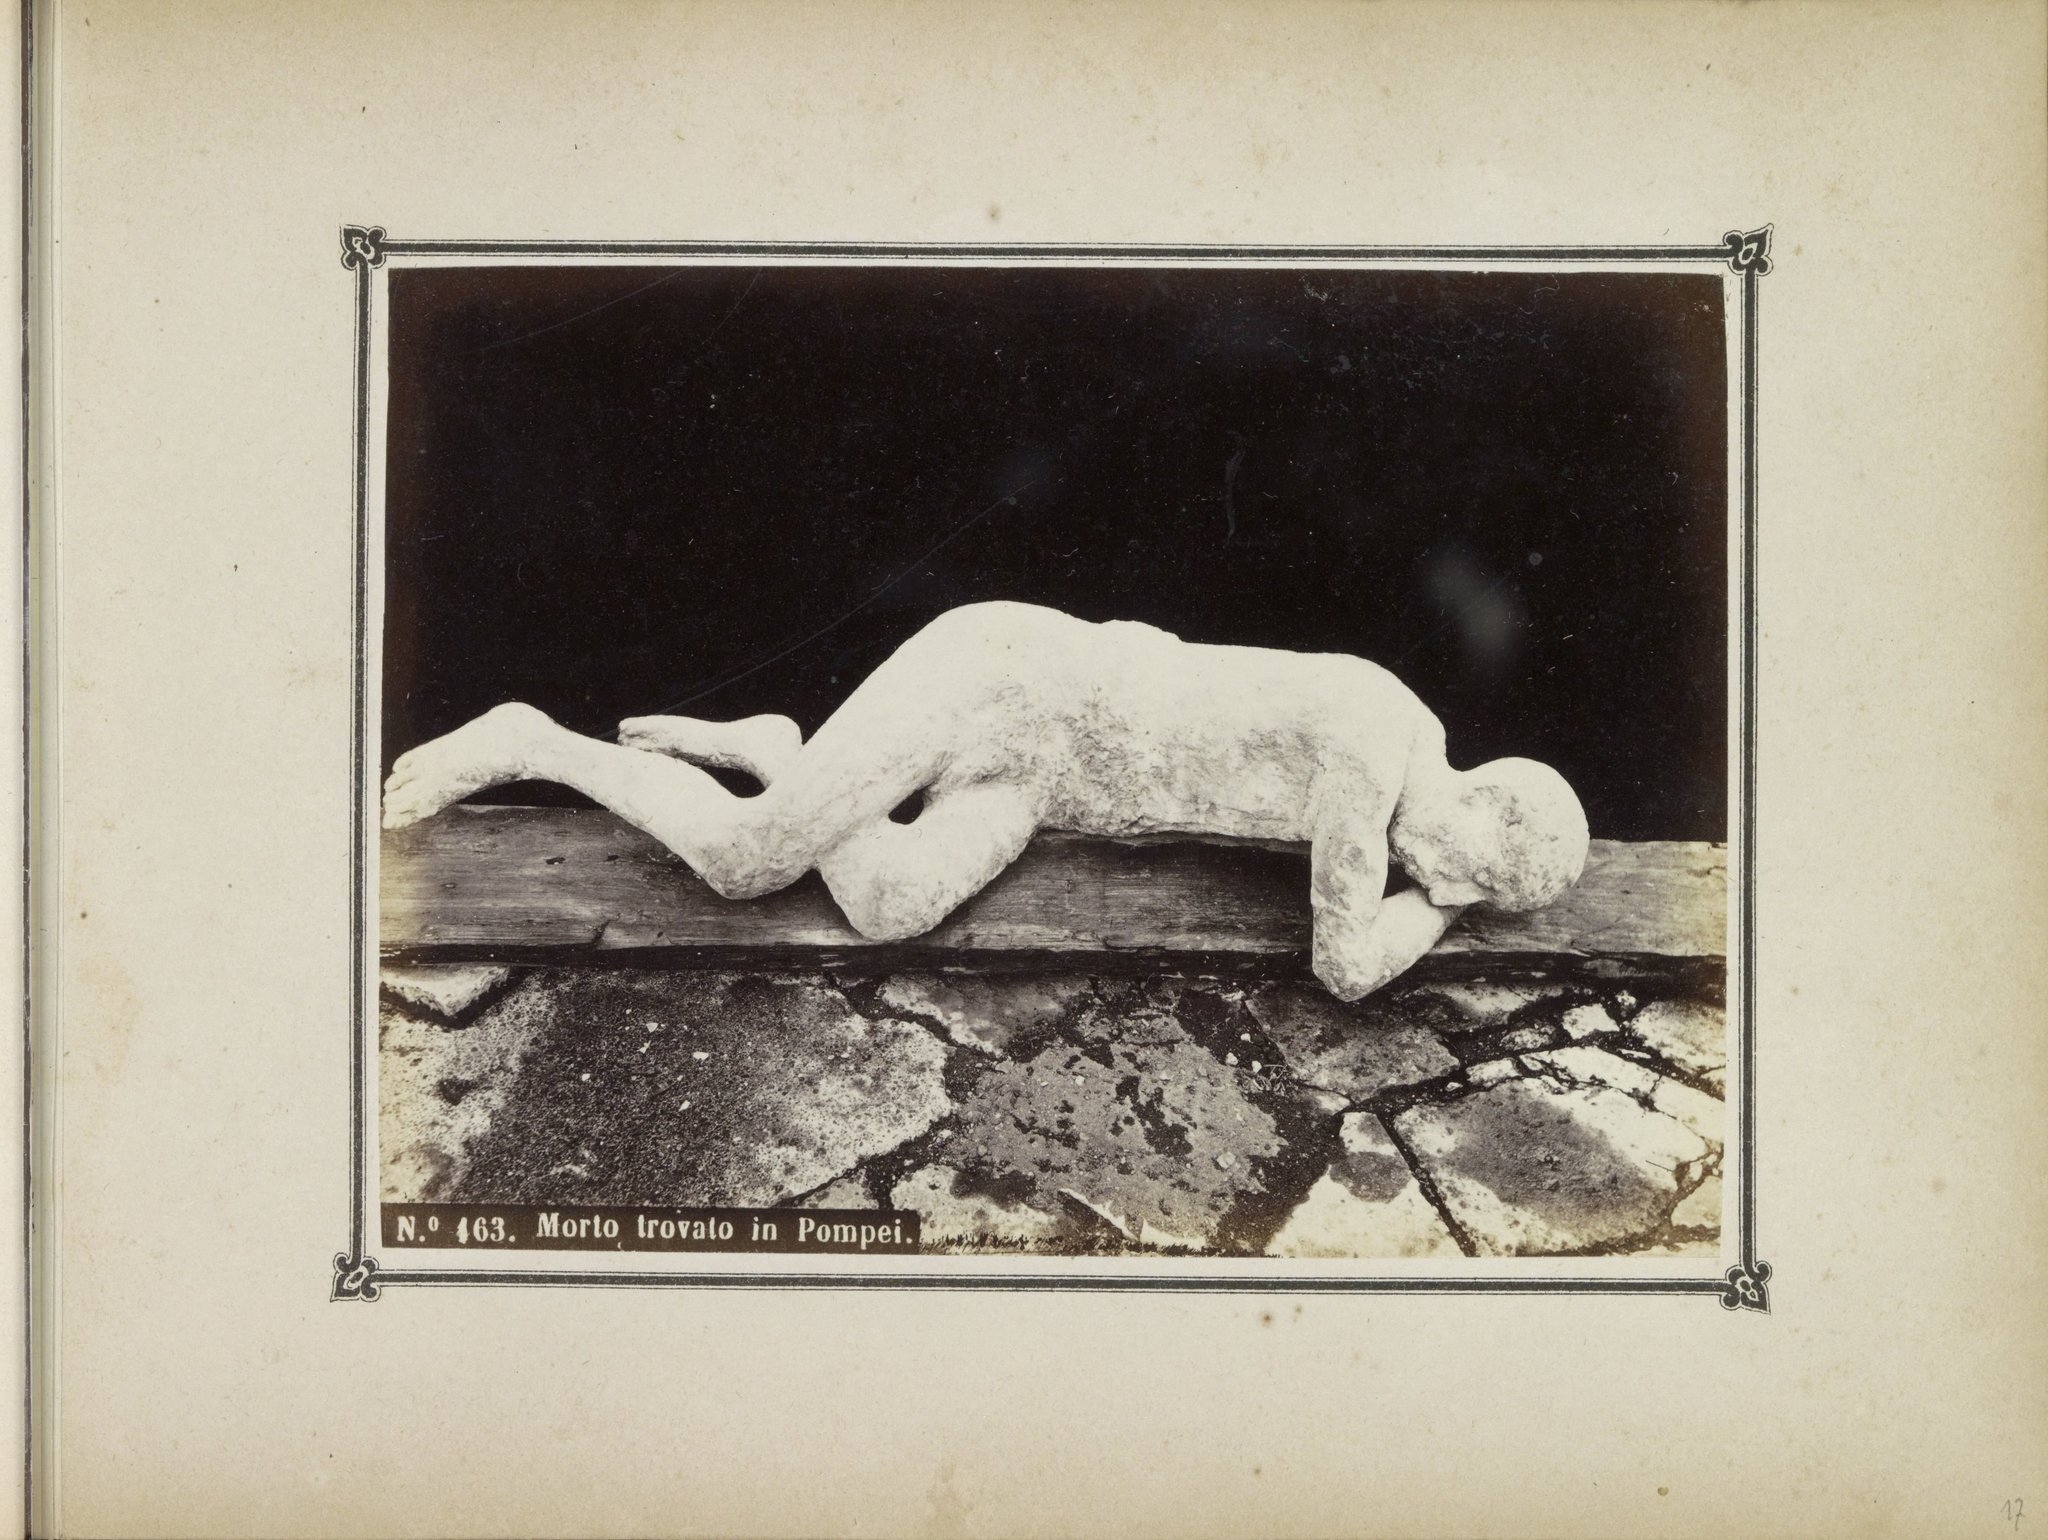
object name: photograph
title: Morto trovato in Pompei.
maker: roberto rive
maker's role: fotograaf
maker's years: 1825-1868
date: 1860-1900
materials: paper, photographic support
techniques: albumen print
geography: pompeii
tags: the corpse, excavation ~ archaeology, pompeii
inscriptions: number: ‘463’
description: Onderdeel van Fotoalbum met opnames van opgravingen in Pompeï door Roberto Rive.